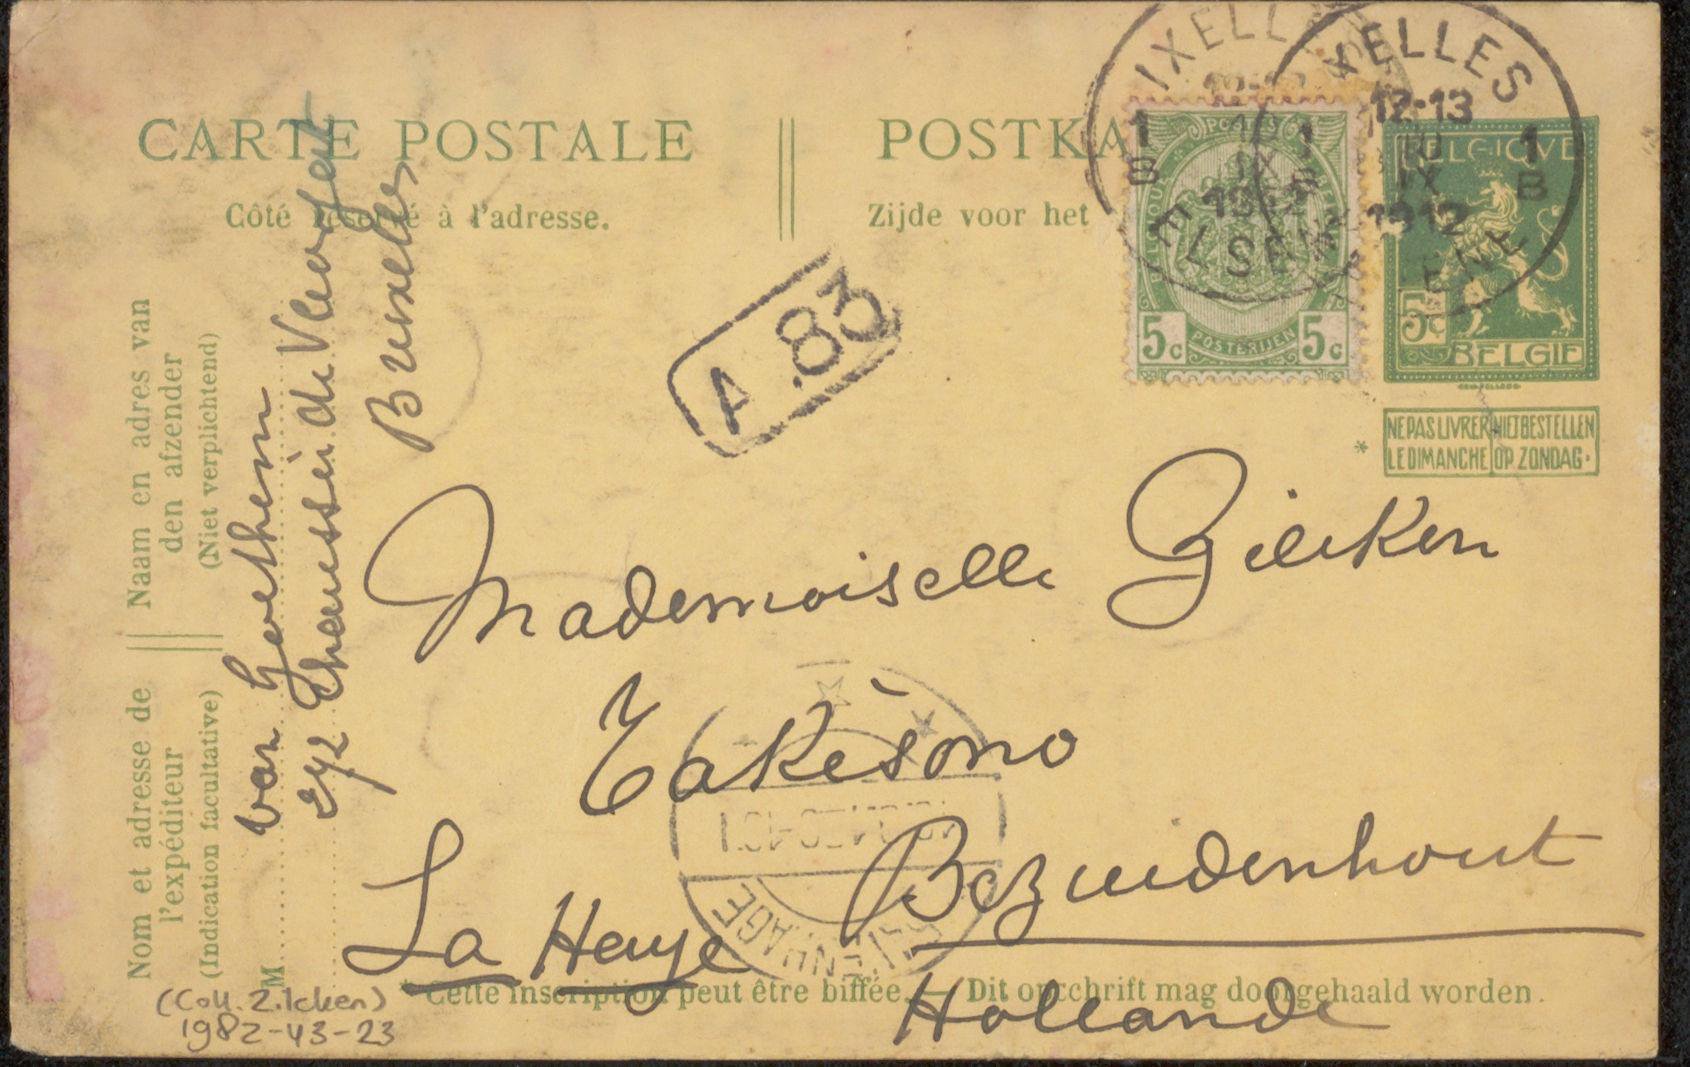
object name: postcard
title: Briefkaart aan Renée Hélène Laure Zilcken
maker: hélène van goethem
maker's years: 1866-1919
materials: cardboard, ink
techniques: pen, writing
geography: brussels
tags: voorburg, print maker, renée hélène laure zilcken, diseases, england